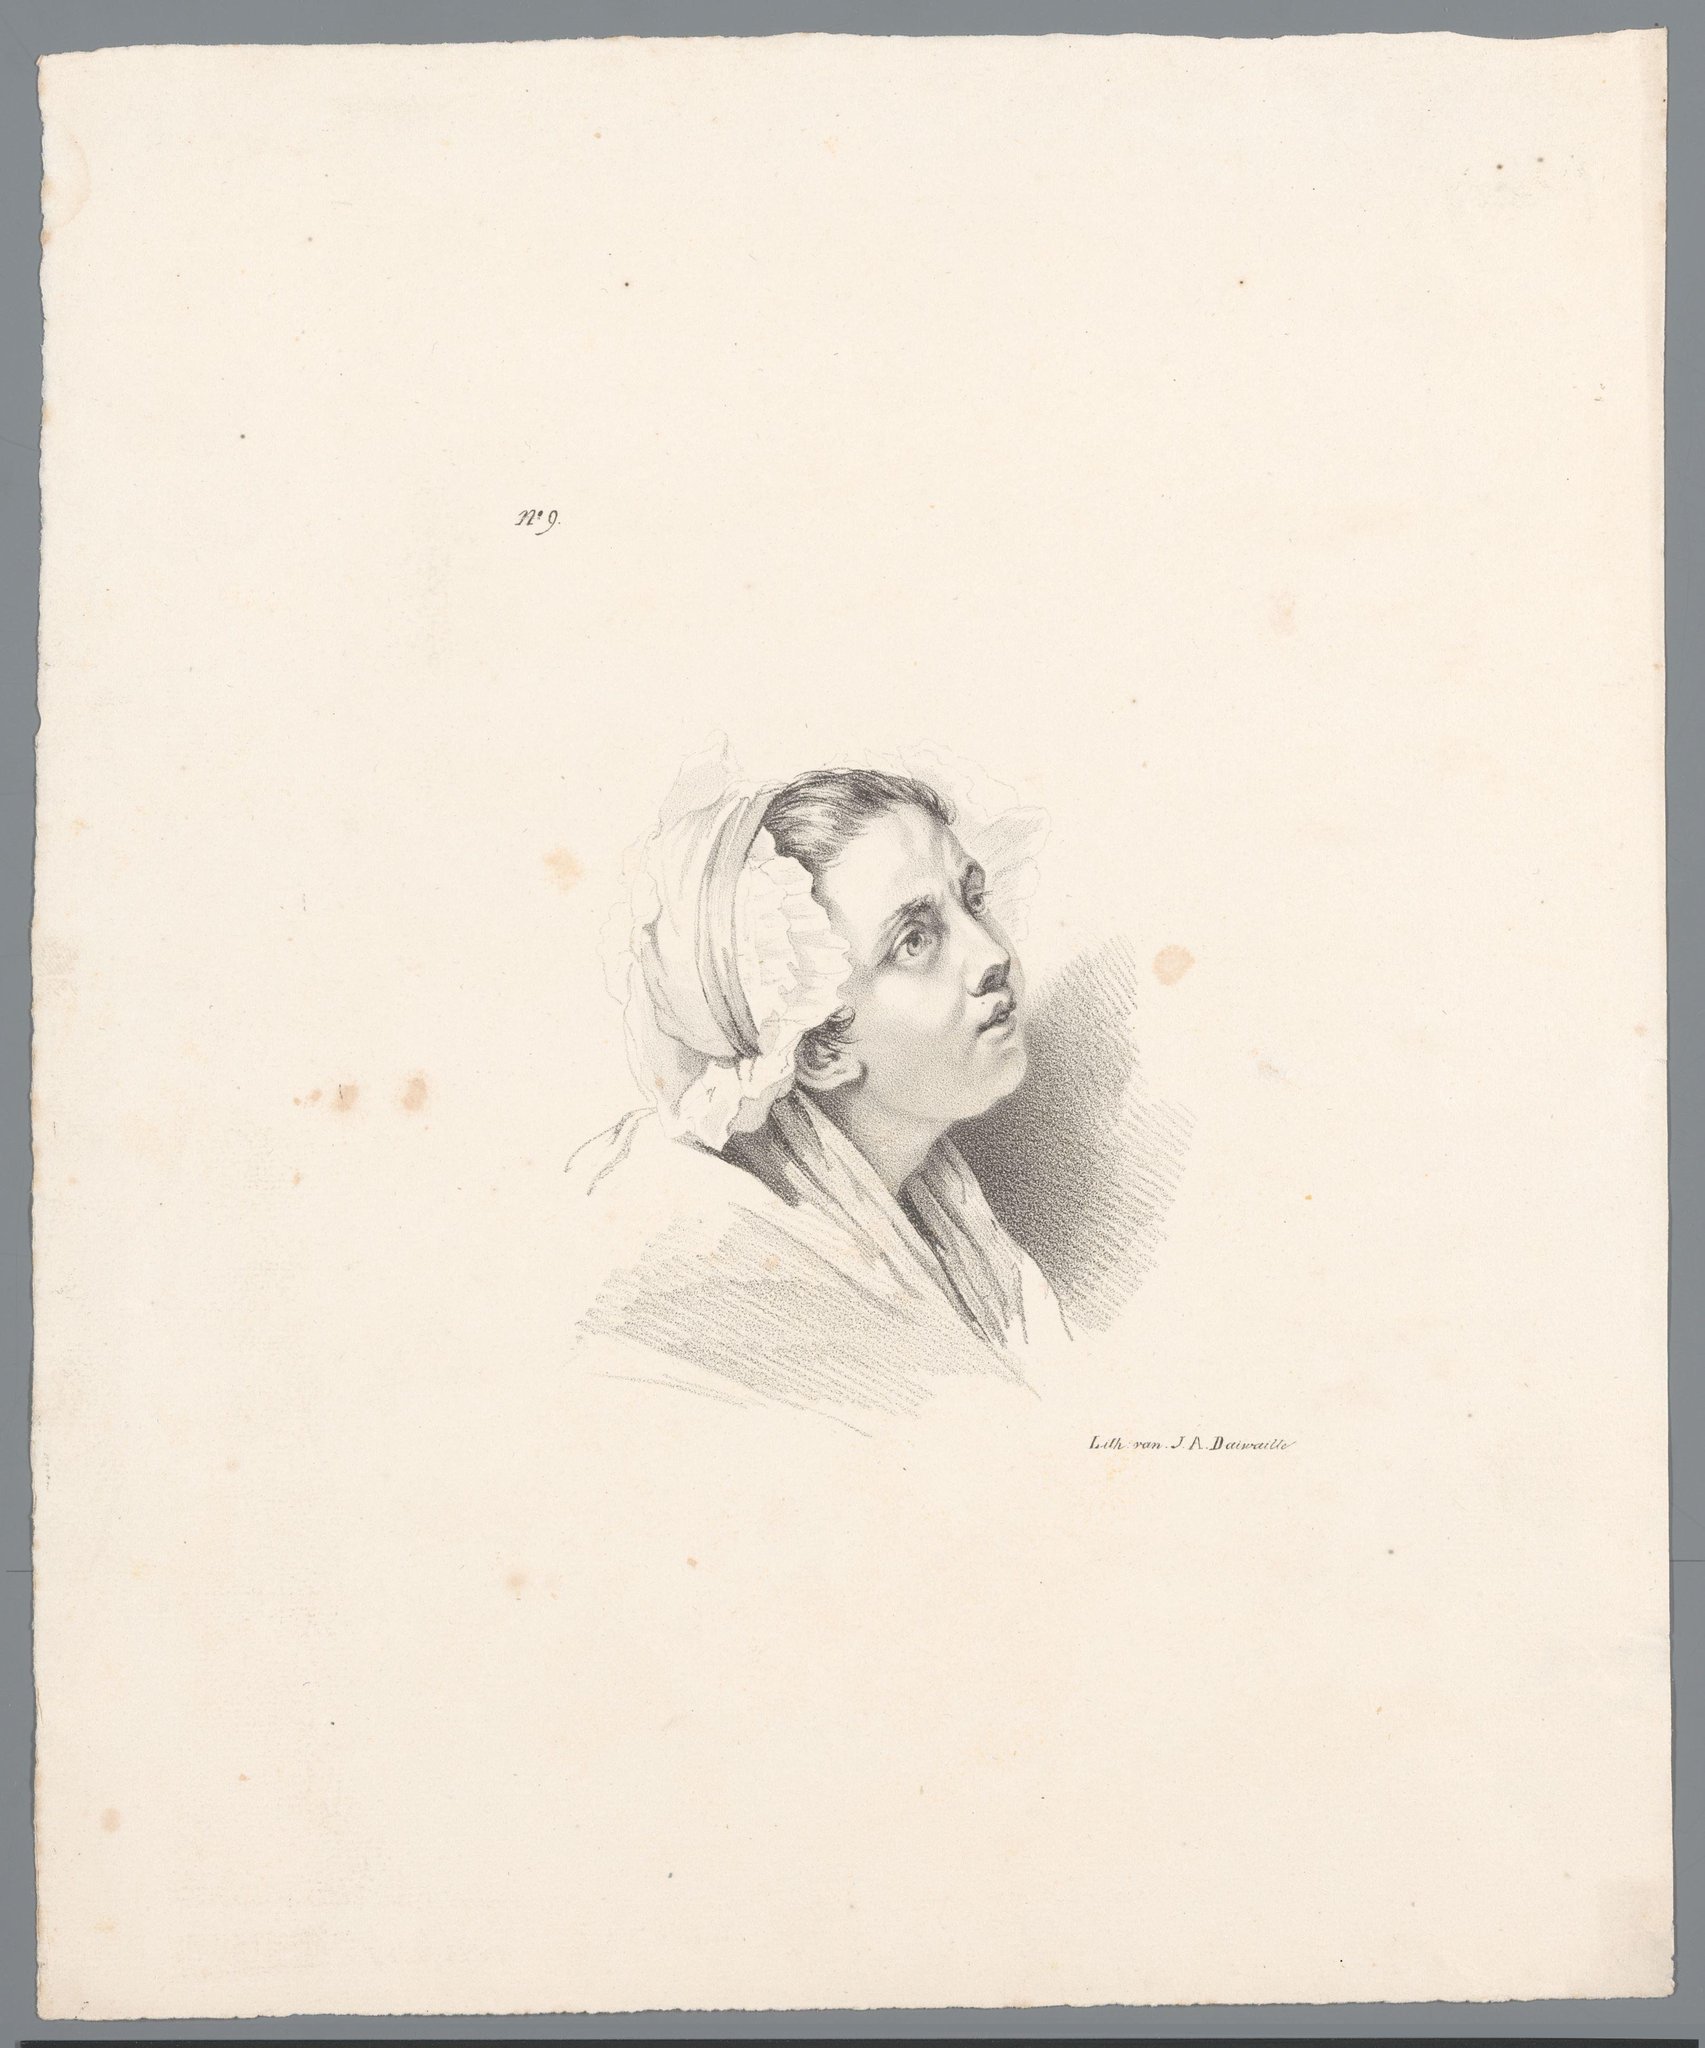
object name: print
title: Meisje met muts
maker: jean augustin daiwaille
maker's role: draughtsman, print maker, printer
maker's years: 1786-1850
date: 1820-1830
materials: paper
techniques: lithograph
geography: amsterdam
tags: adolescent, young woman, maiden, frowned eyebrows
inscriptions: collector's mark: Lugt 2228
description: 'Hartstochten na J.B. Greuze' bestaat uit twee of drie genummerde reeksen. (Sommige nummers komen drie keer voor op drie verschillende afbeeldingen.) Binnen deze omslag bevinden zich achttien verschillende afbeeldingen. Mogelijk heeft dit te maken met de twee momenten waarop Daiwaille de reeks uitgaf, ten tijden van zijn directeurschap aan de Rijksakademie in Amsterdam en daarna als zelfstandige. De omslag behoort waarschijnlijk bij een van deze twee series. Zie Marres-Schretlen, 2001.